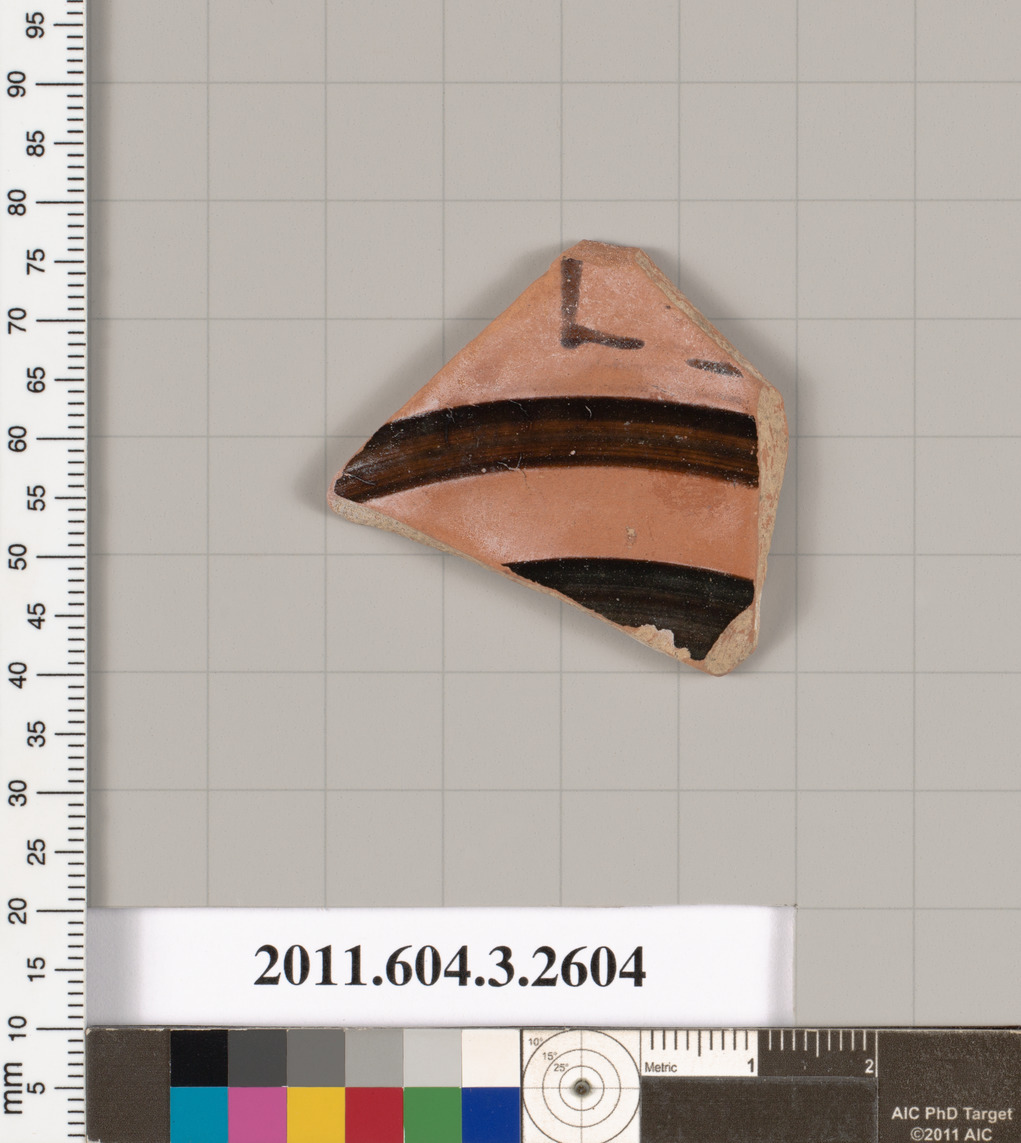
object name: kylix fragment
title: Terracotta fragment of a kylix (drinking cup)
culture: greek, attic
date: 550-526 BCE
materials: terracotta